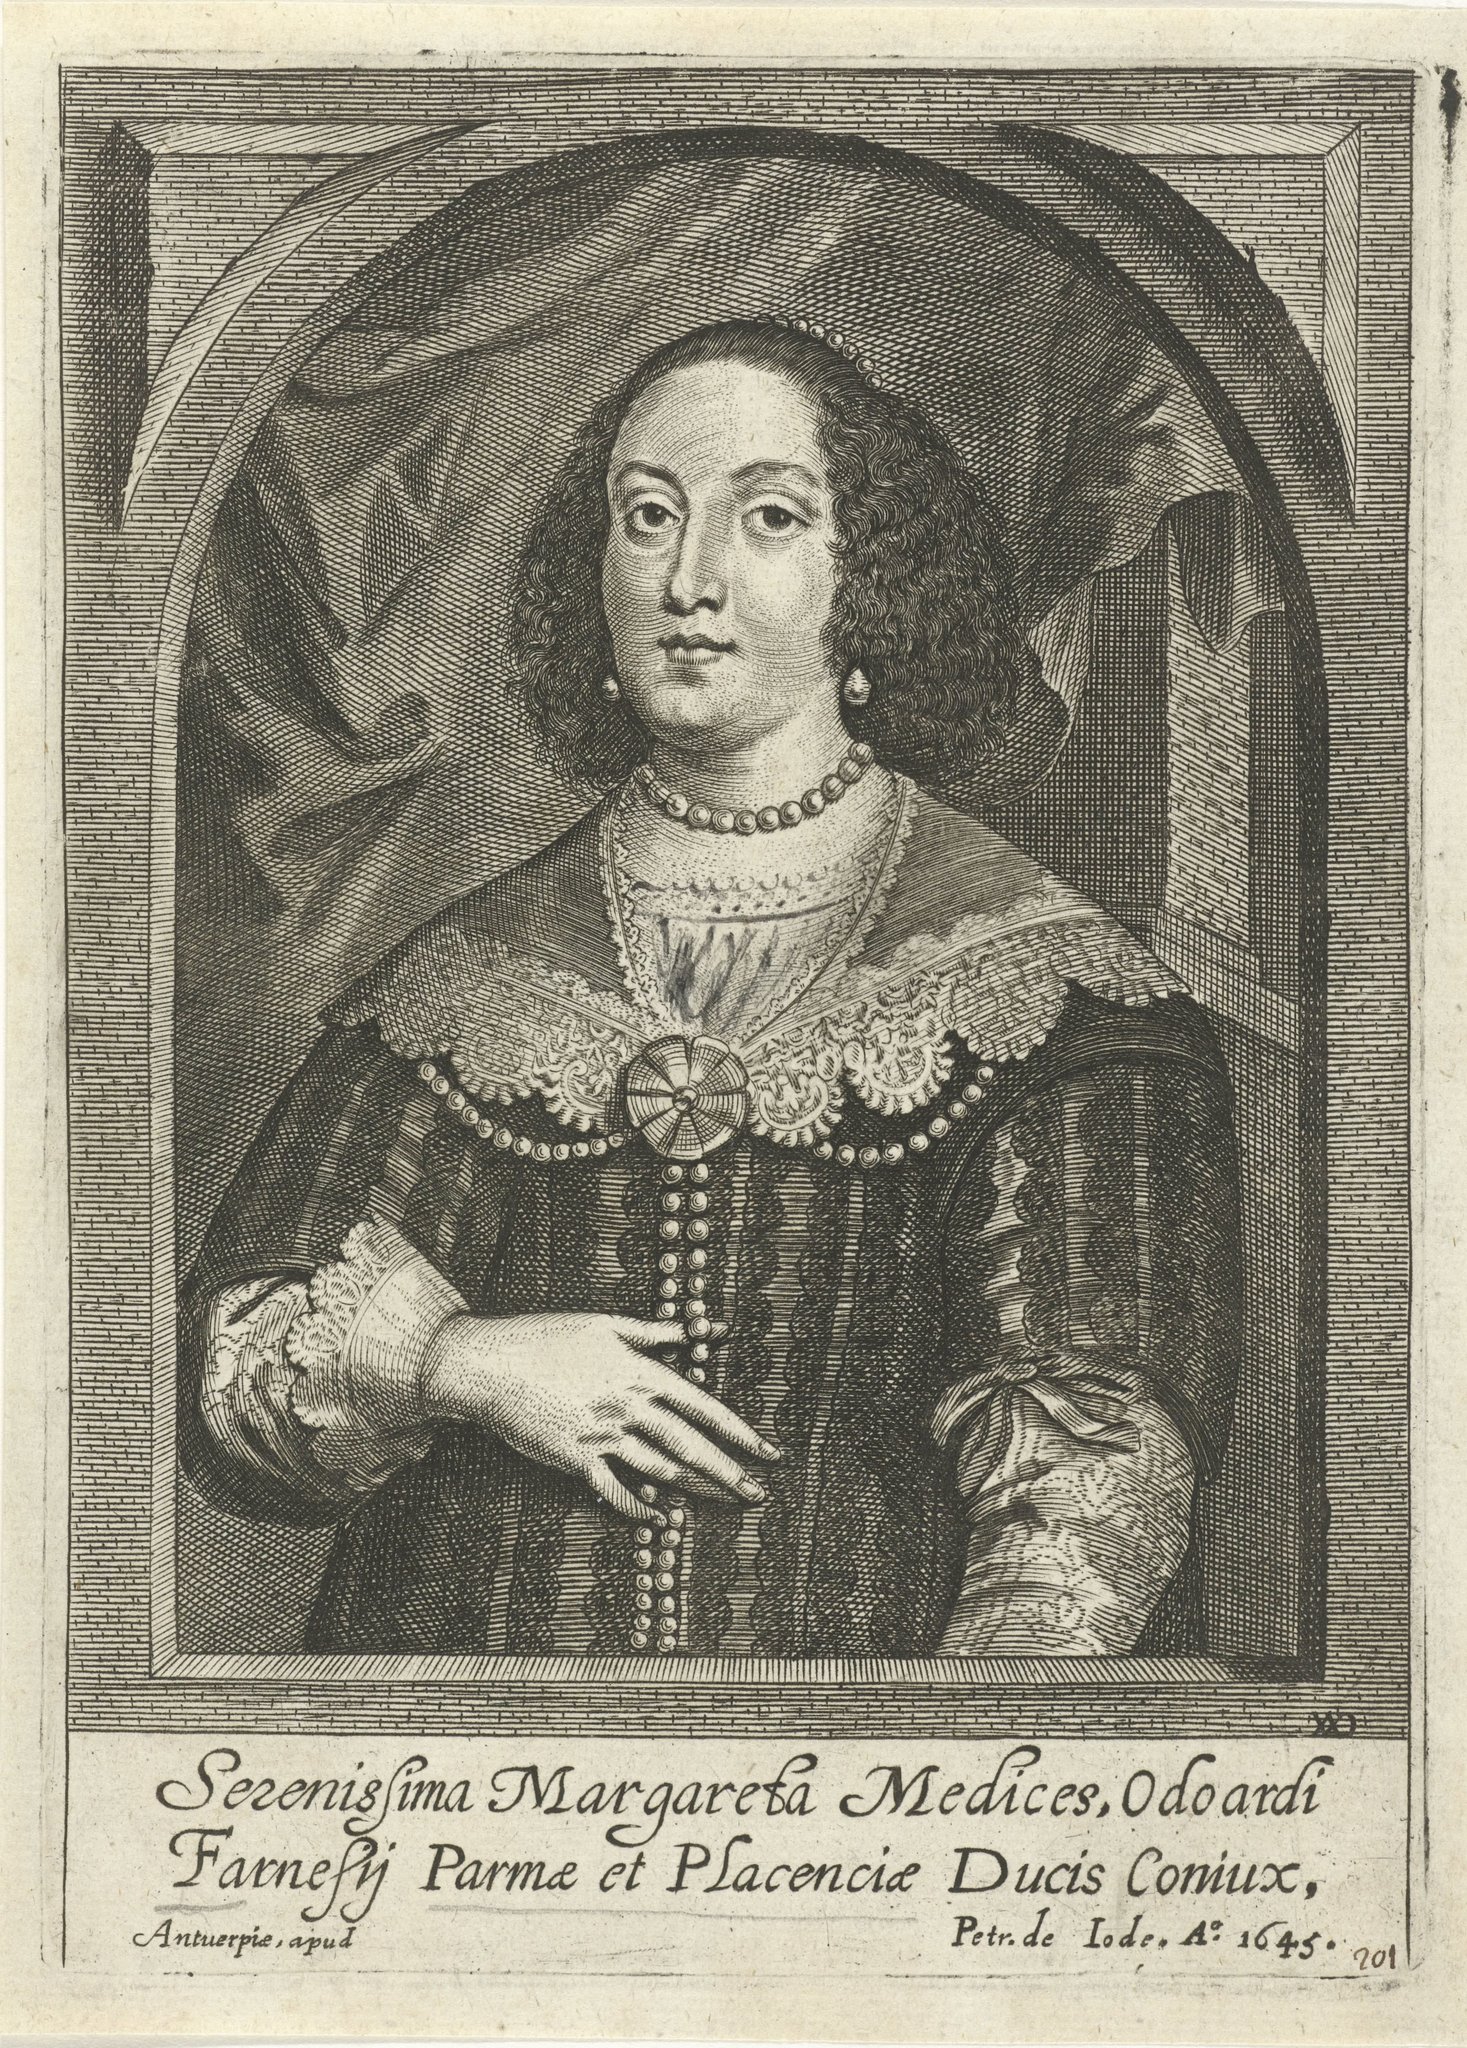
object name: print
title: Theater van bisschoppen, keizers, koningen, hertogen, prinsen, enz.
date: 1645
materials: paper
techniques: engraving, etching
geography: antwerp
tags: margherita de' medici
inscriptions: inscription: ‘201’, collector's mark: Lugt 2228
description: Busteportret van Margaretha de Medici, gemalin van Odoardo Farnese. Ze houdt haar rechterhand tegen haar lichaam aan. Rechtsonder: XXI. Het portret is gevat in een boogvormige omlijsting. In de marge een tweeregelig onderschrift in het Latijn.